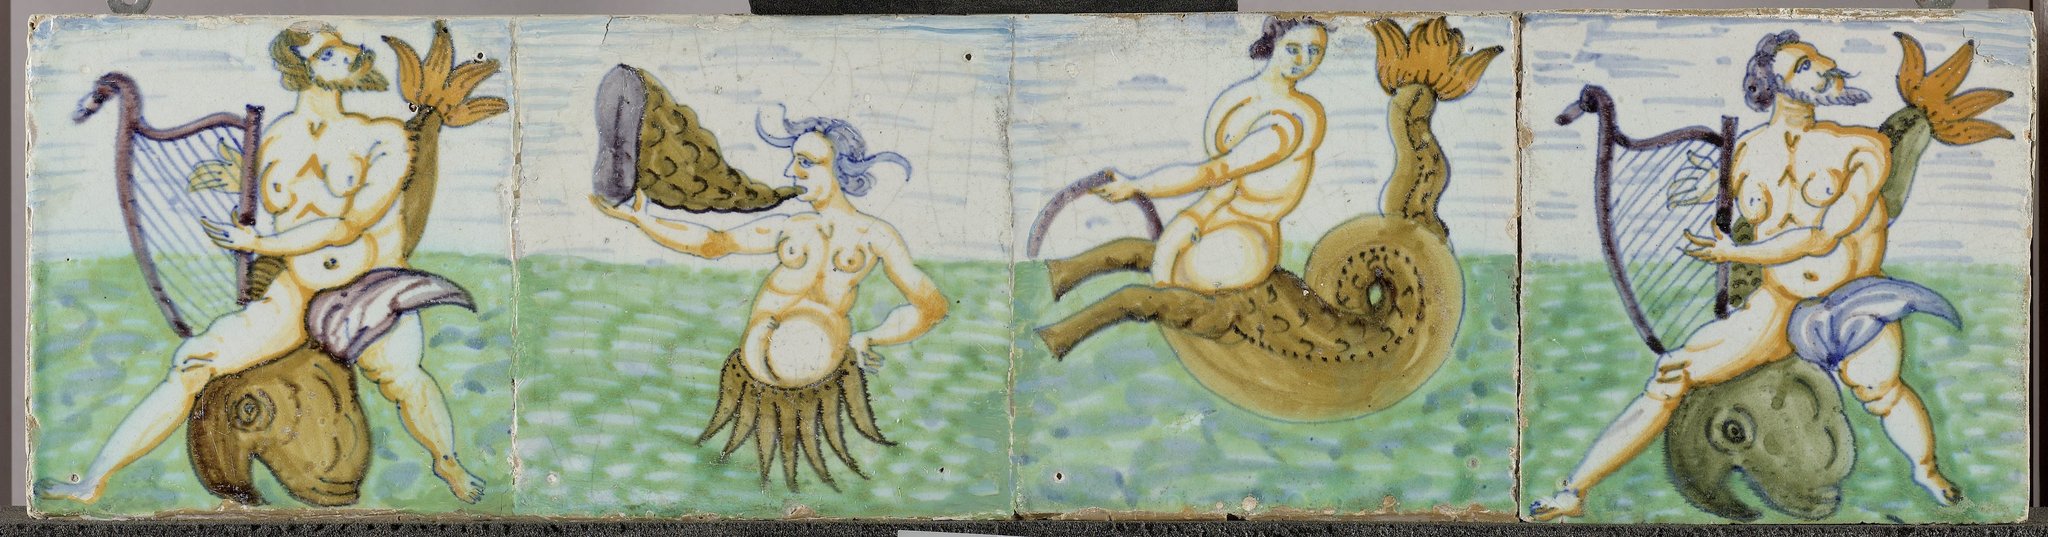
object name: tegelveld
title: Veld van vier tegels met zeewezens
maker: Anonymous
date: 1590-1625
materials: earthenware, glaze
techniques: maiolica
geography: rotterdam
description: Veld van vier tegels (1 x 4) elk met een veelkleurig (blauw, oranjegeel, groen, bruin en paars) zeewezen. De tegels uiterst links en rechts stellen Arion met zijn harp op de rug van een dolfijn voor. De tweede tegel van links stelt een klinkhoorn blazende triton voor, de triton op de tegel ernaast met een lange krullende staart, houdt een touw vast.